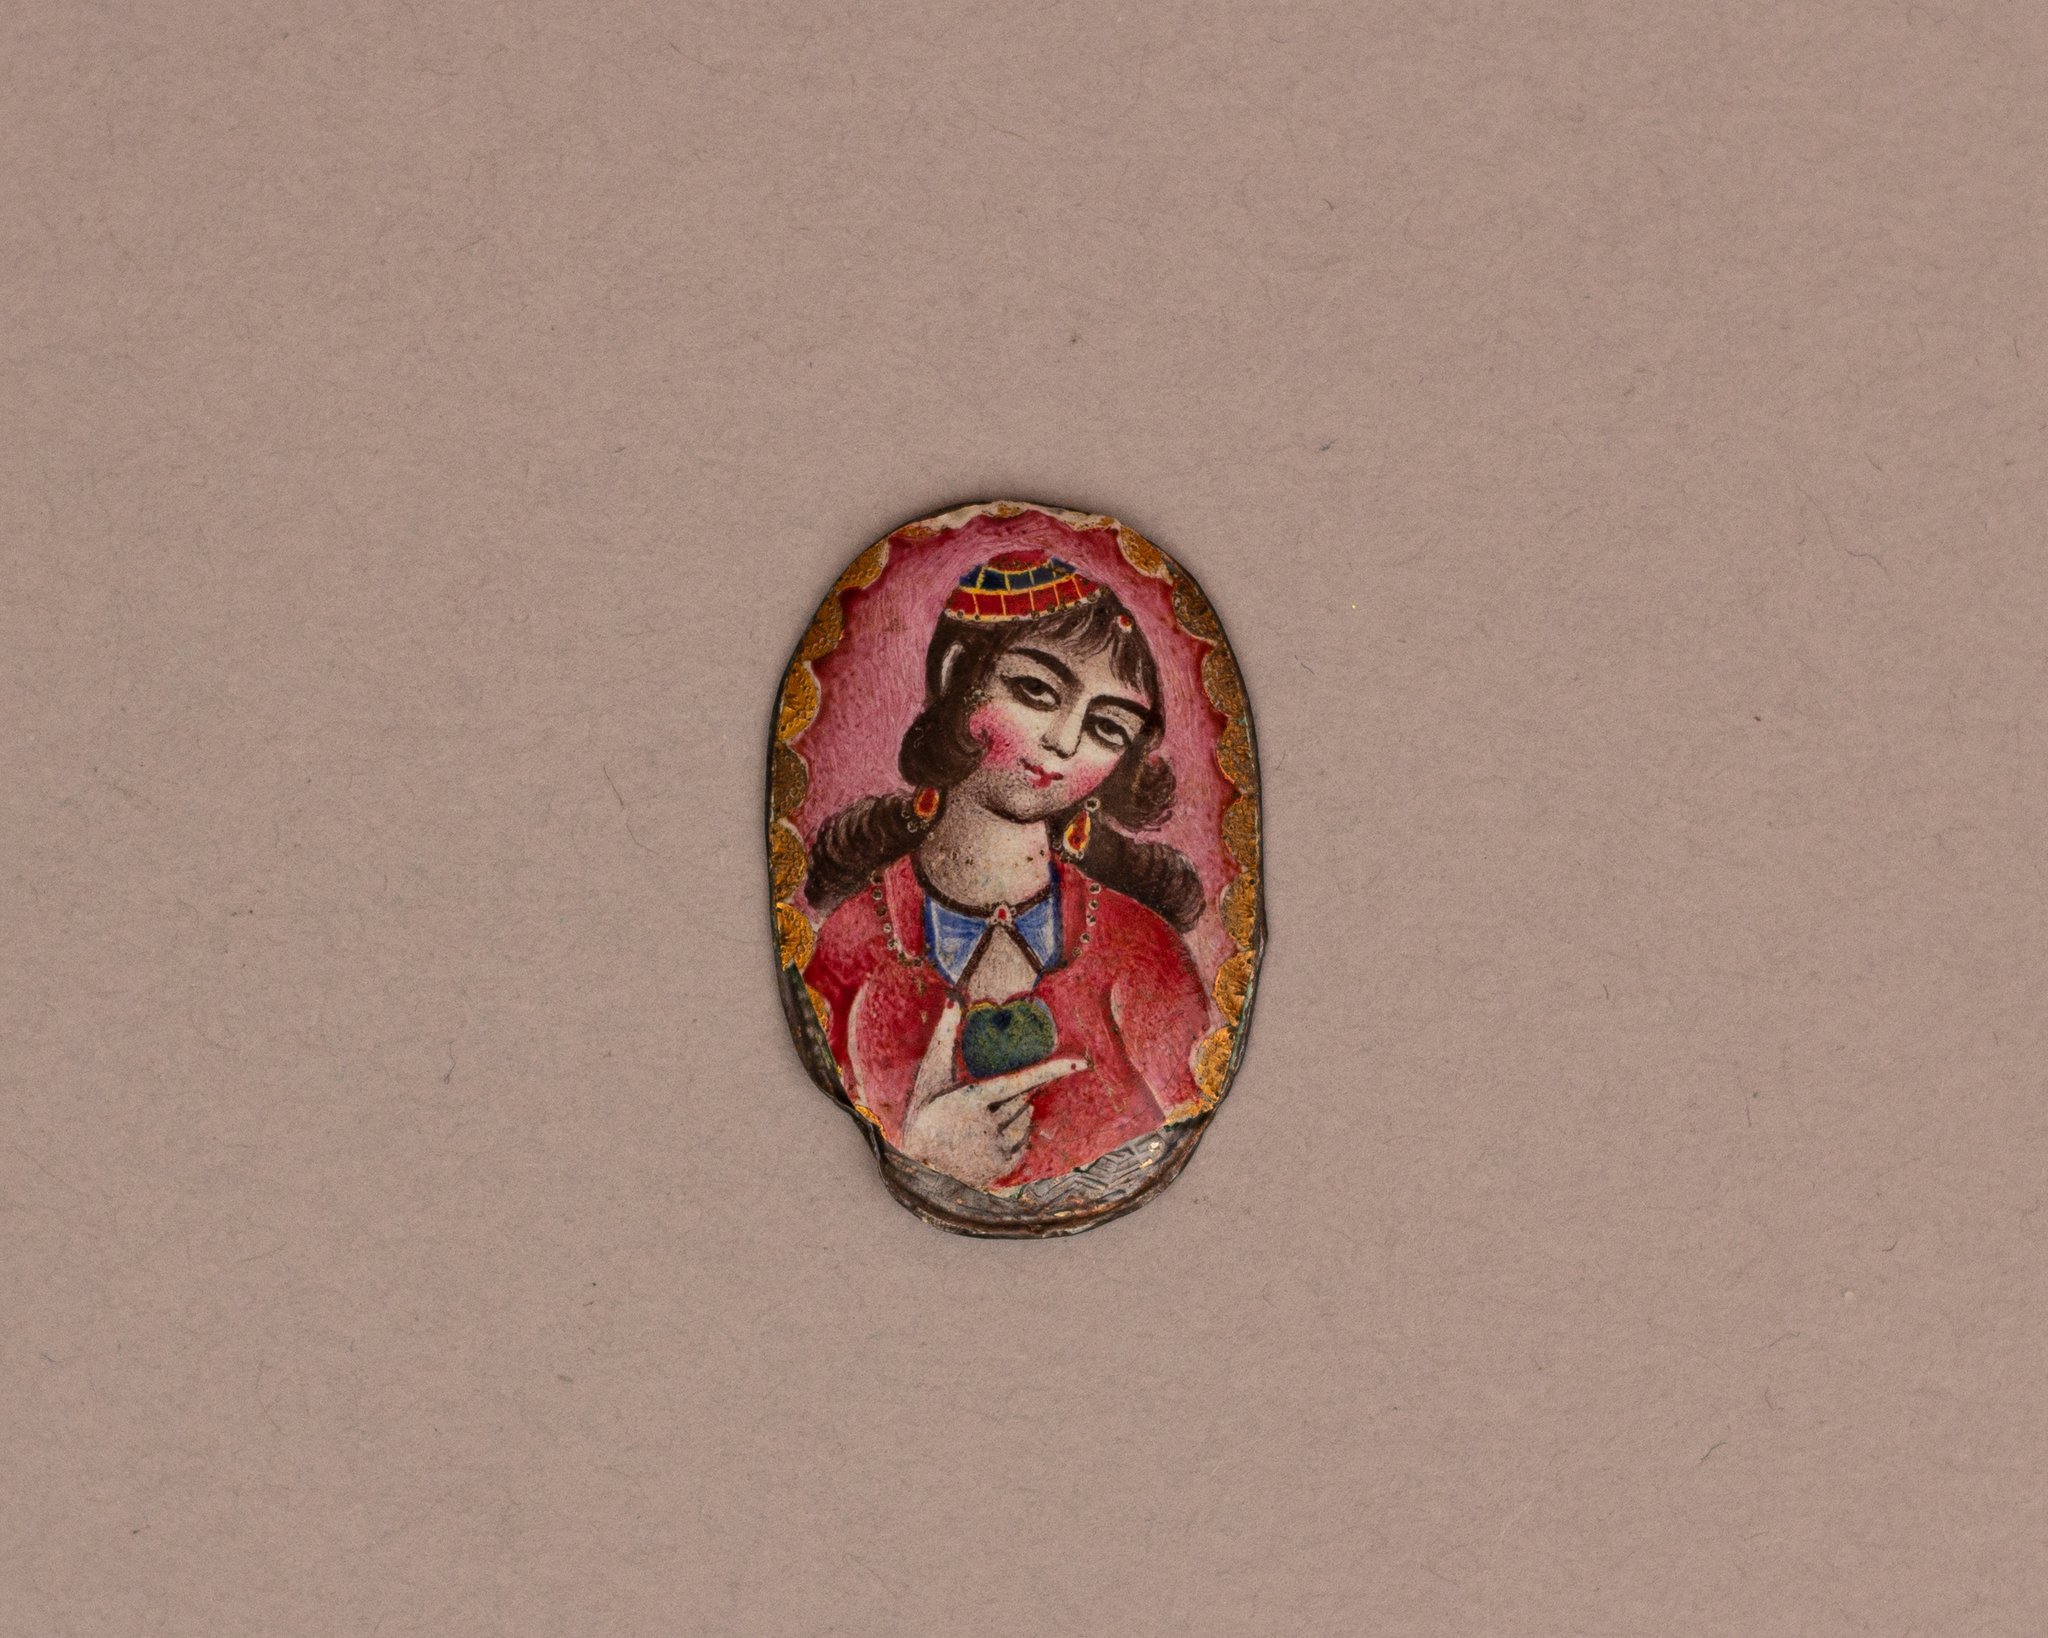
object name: disk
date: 1767-1800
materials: enamel, gold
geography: iran